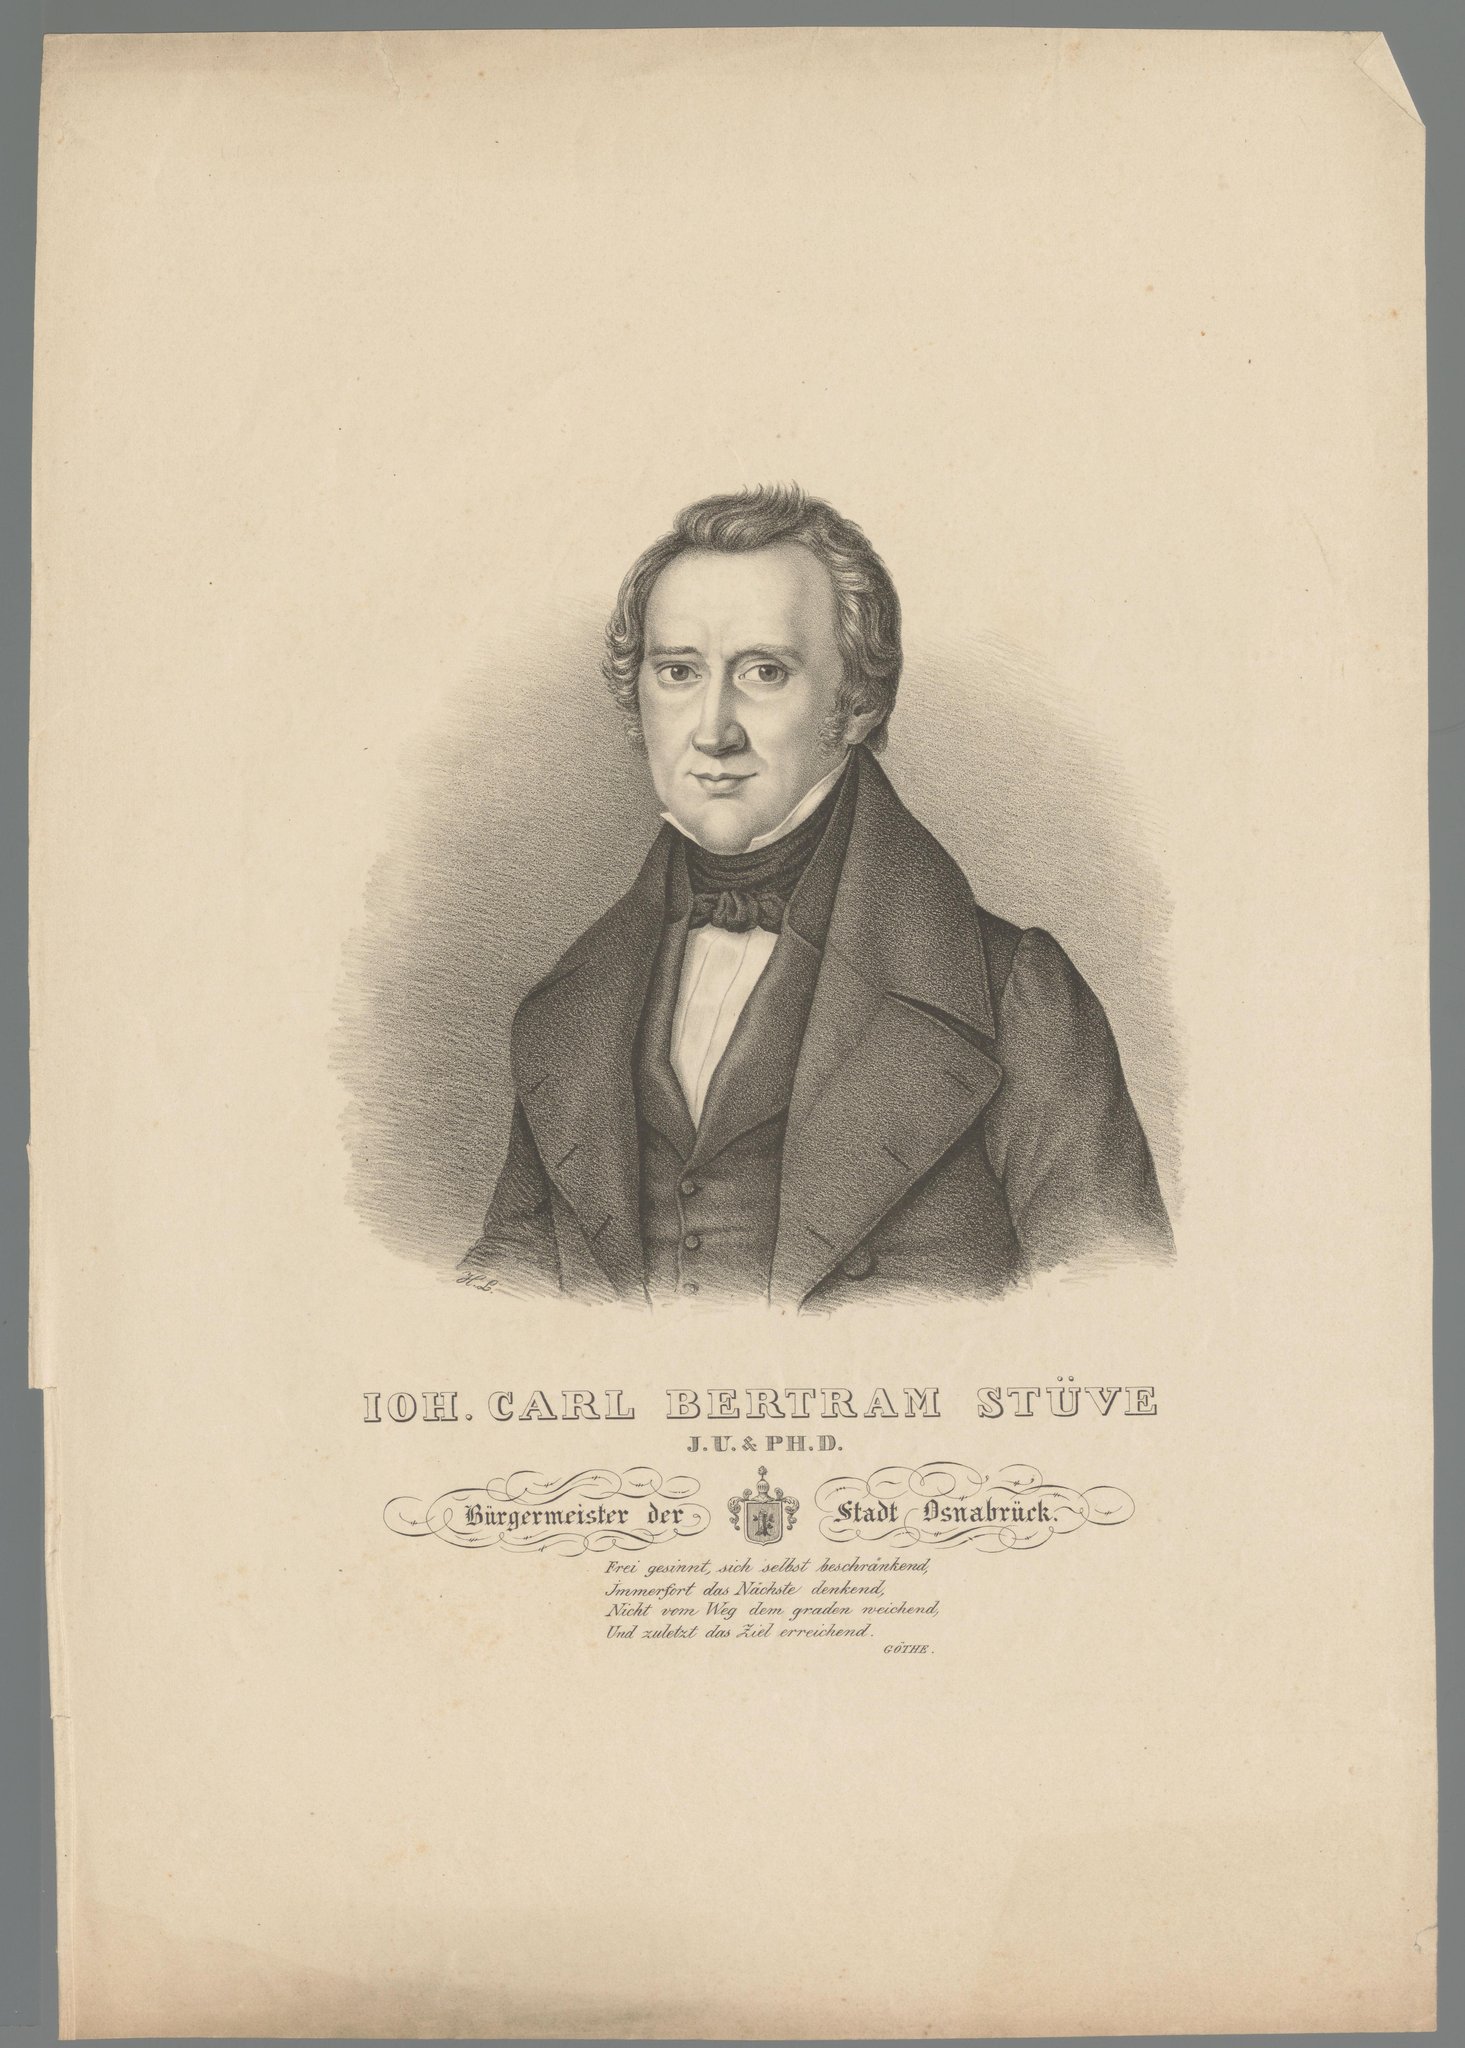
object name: print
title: Portret van Johann Karl Bertram Stüve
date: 1820-1860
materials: paper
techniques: lithograph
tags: mayor, adult man, historical persons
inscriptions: watermark, collector's mark: Lugt 2228